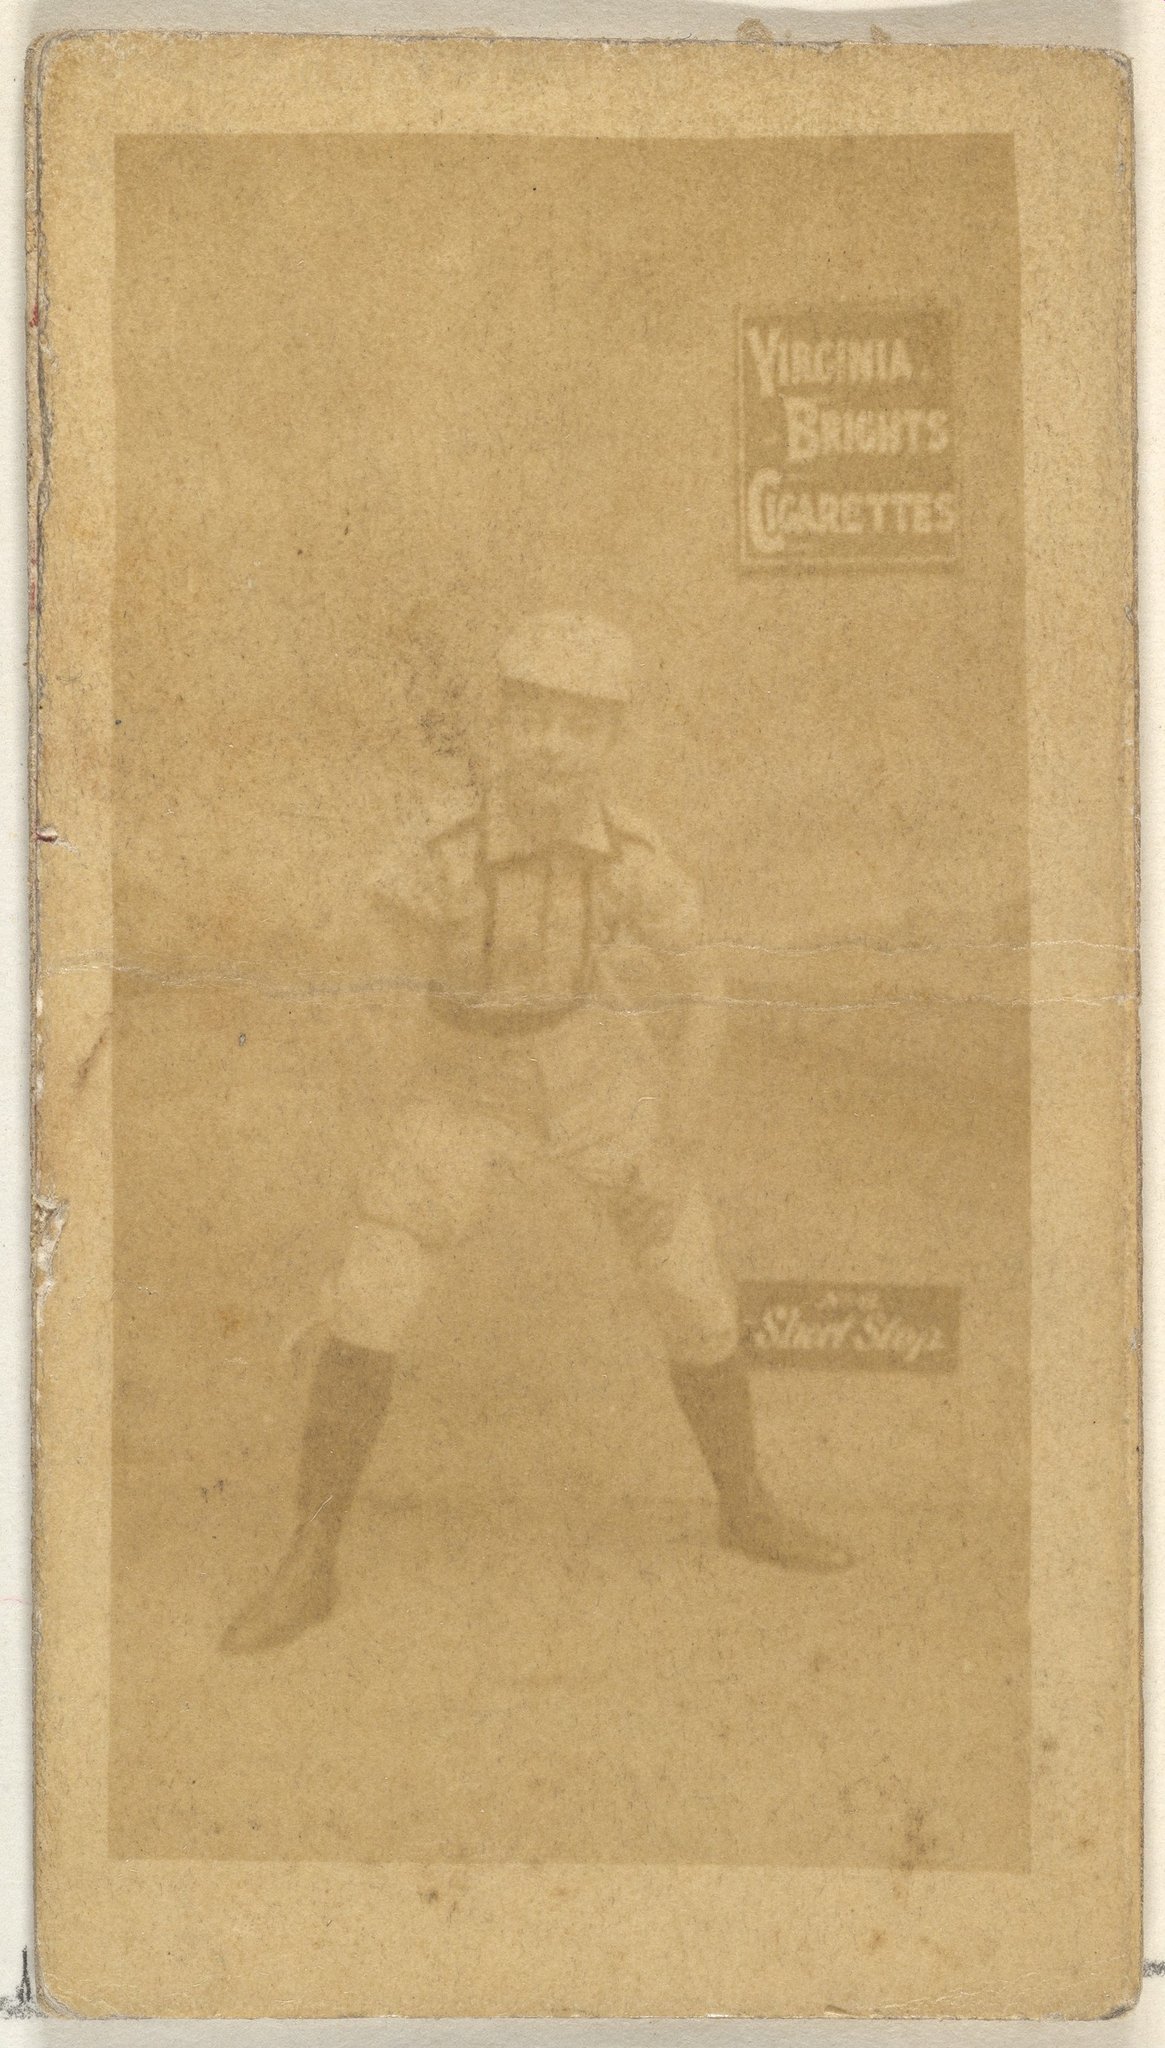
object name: baseball card, photograph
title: Shortstop, from the Girl Baseball Players series (N48, Type 2) for Virginia Brights Cigarettes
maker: allen & ginter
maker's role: publisher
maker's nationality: american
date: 1886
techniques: albumen silver print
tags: portraits,women,baseball,athletes